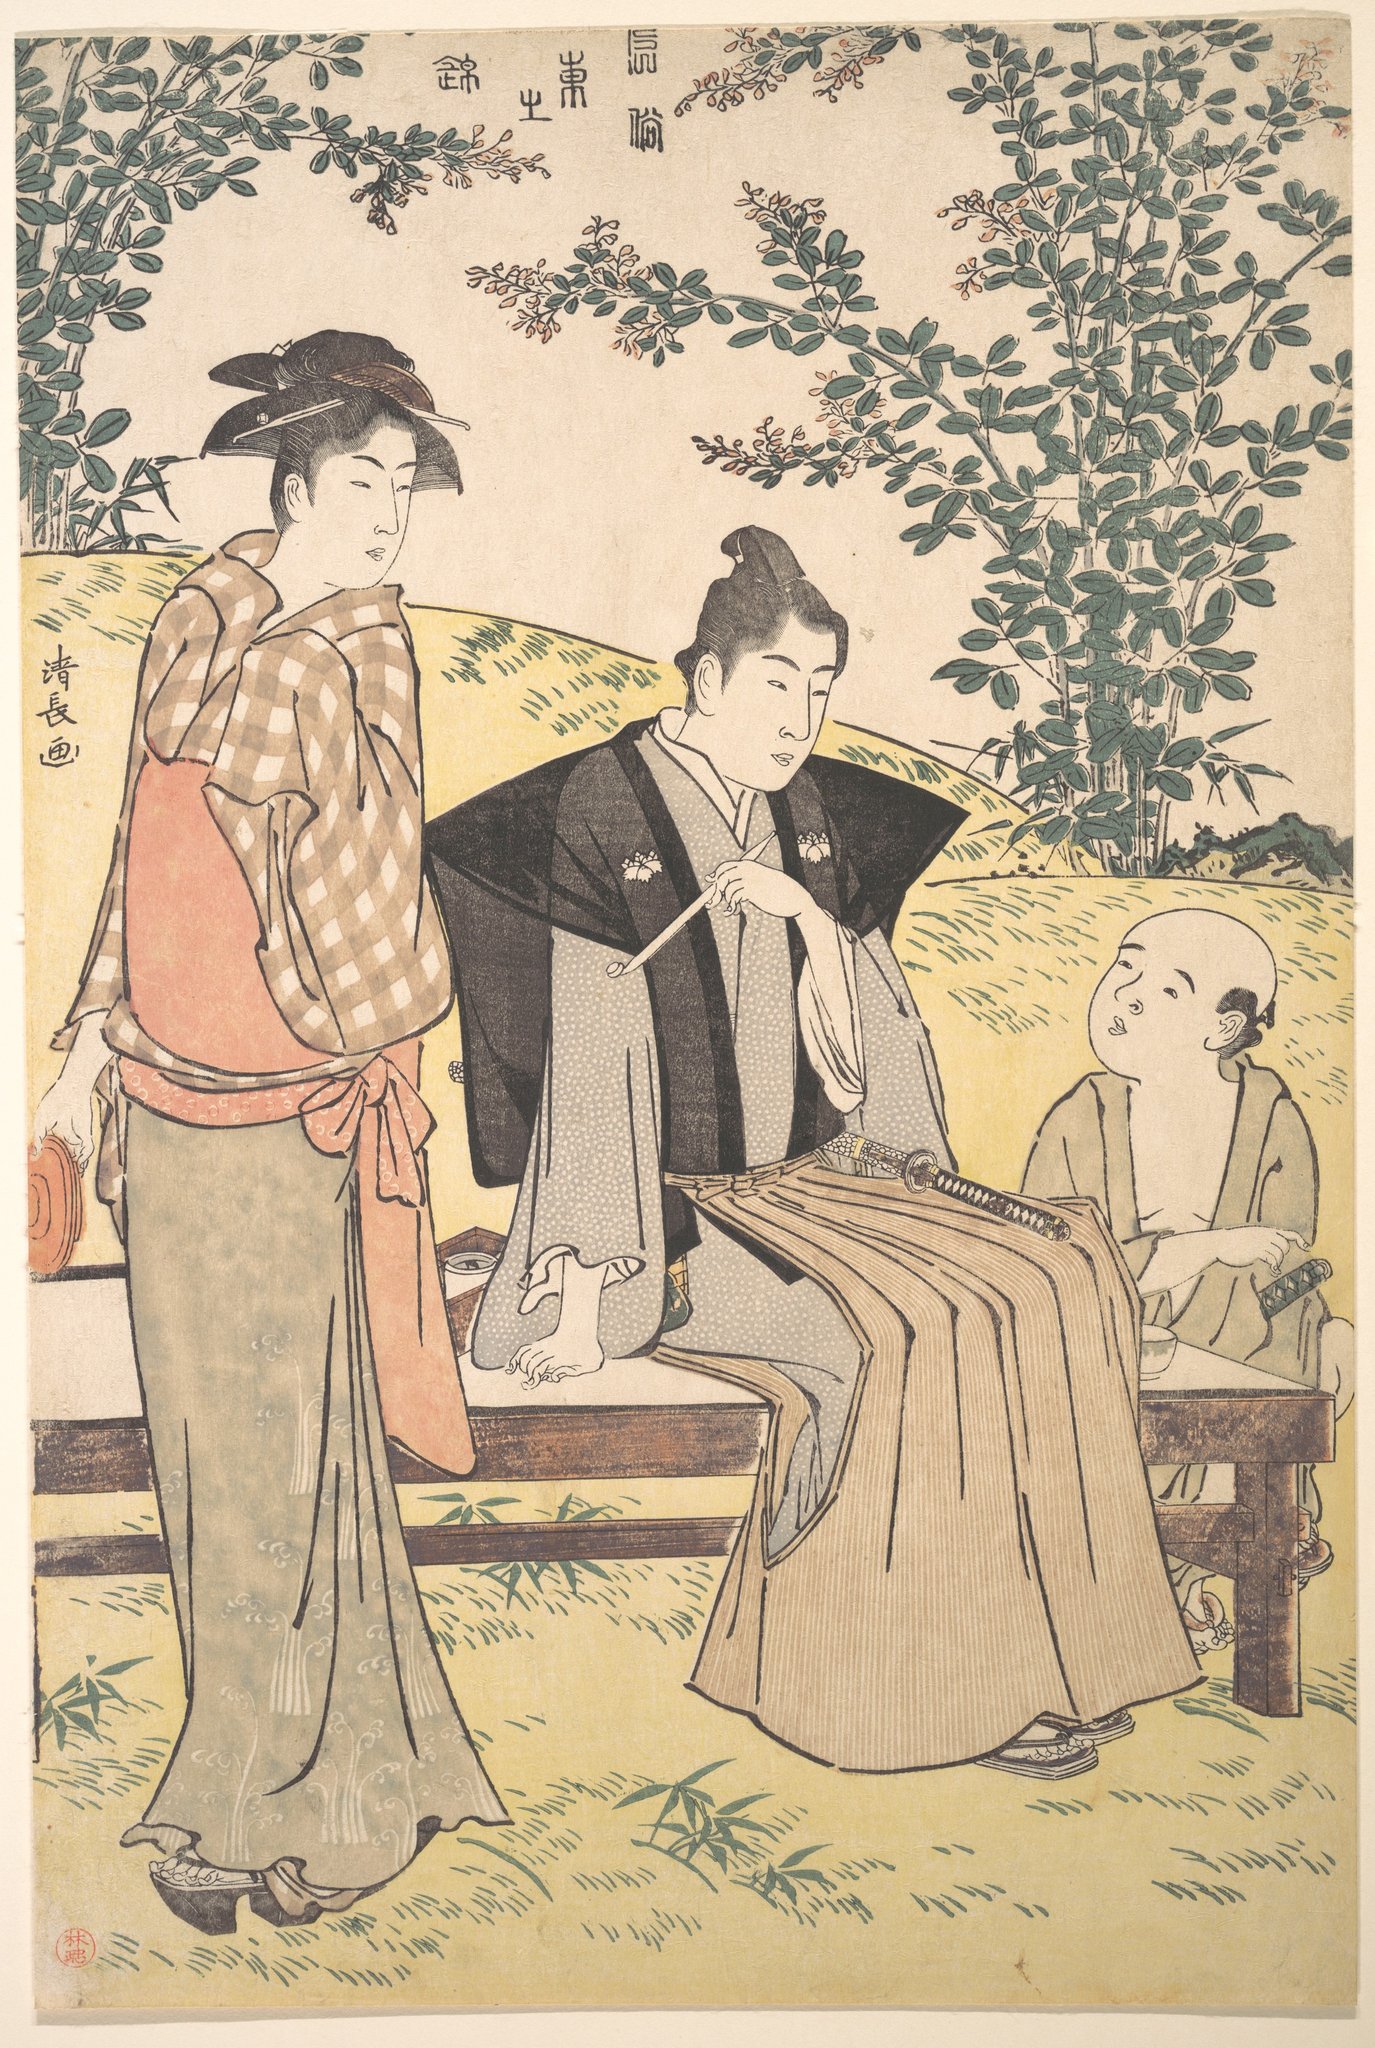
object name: print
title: Viewing the Bush Clover at Hagidera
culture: japanese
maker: torii kiyonaga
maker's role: artist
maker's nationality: japanese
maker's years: 1752-1815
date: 1785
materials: ink, paper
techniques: woodblock print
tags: men,women,benches